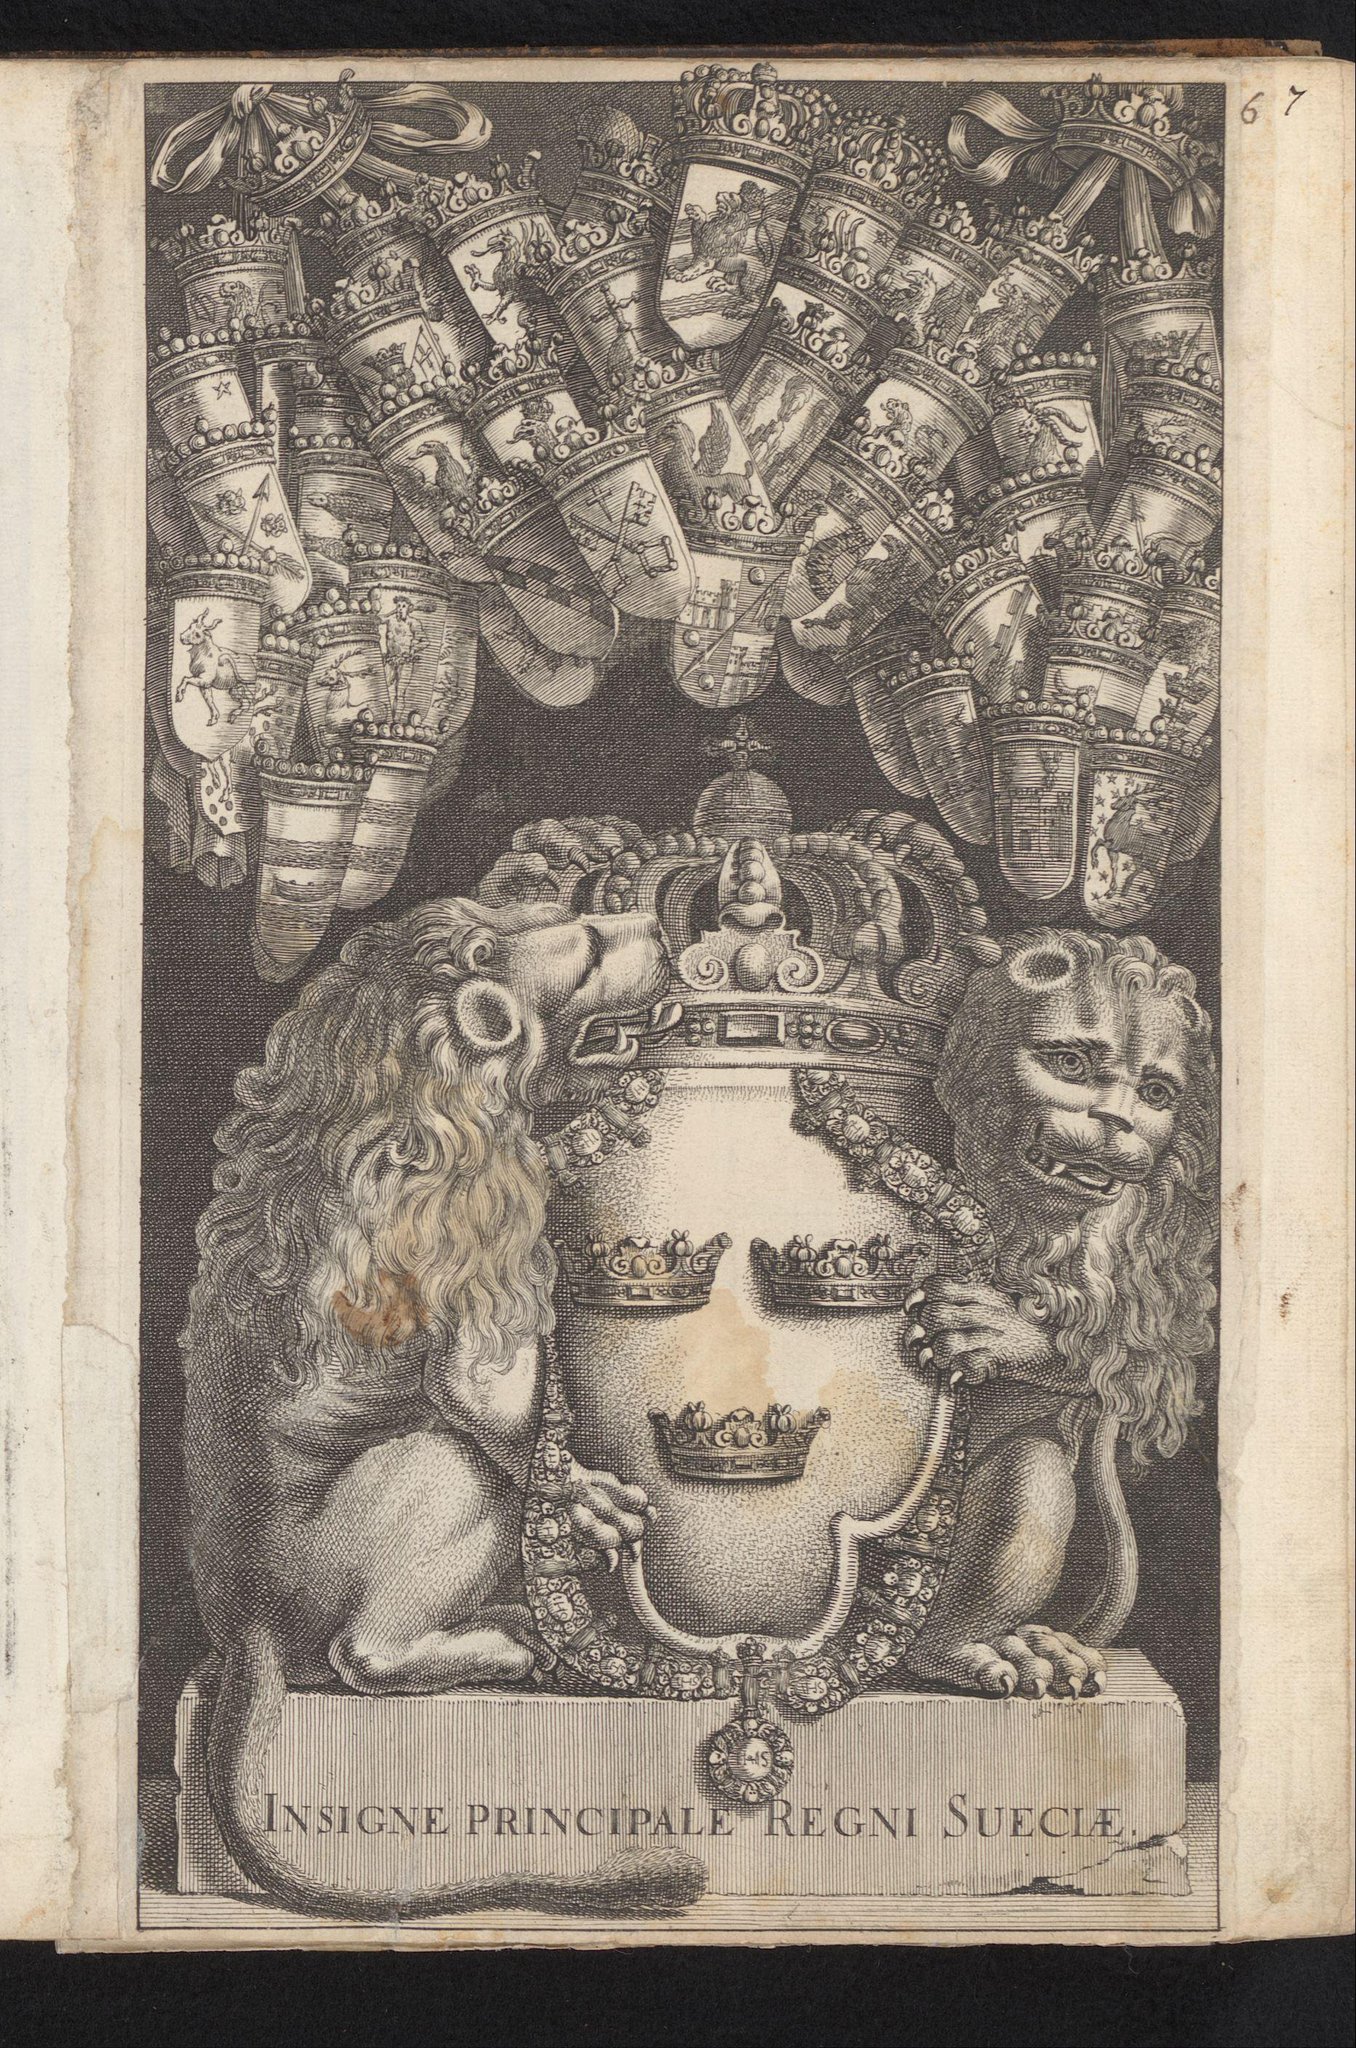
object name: album leaf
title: Wapen van Zweden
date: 1669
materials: paper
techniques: engraving, etching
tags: coat of arms (as symbol of the state, etc.)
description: Schild met het wapen van Zweden en de keten van de orde van de Serafijnen, geflankeerd door twee leeuwen. Daarboven meer gekroonde wapenschilden van het Zweedse rijk. De prent maakt deel uit van een album.